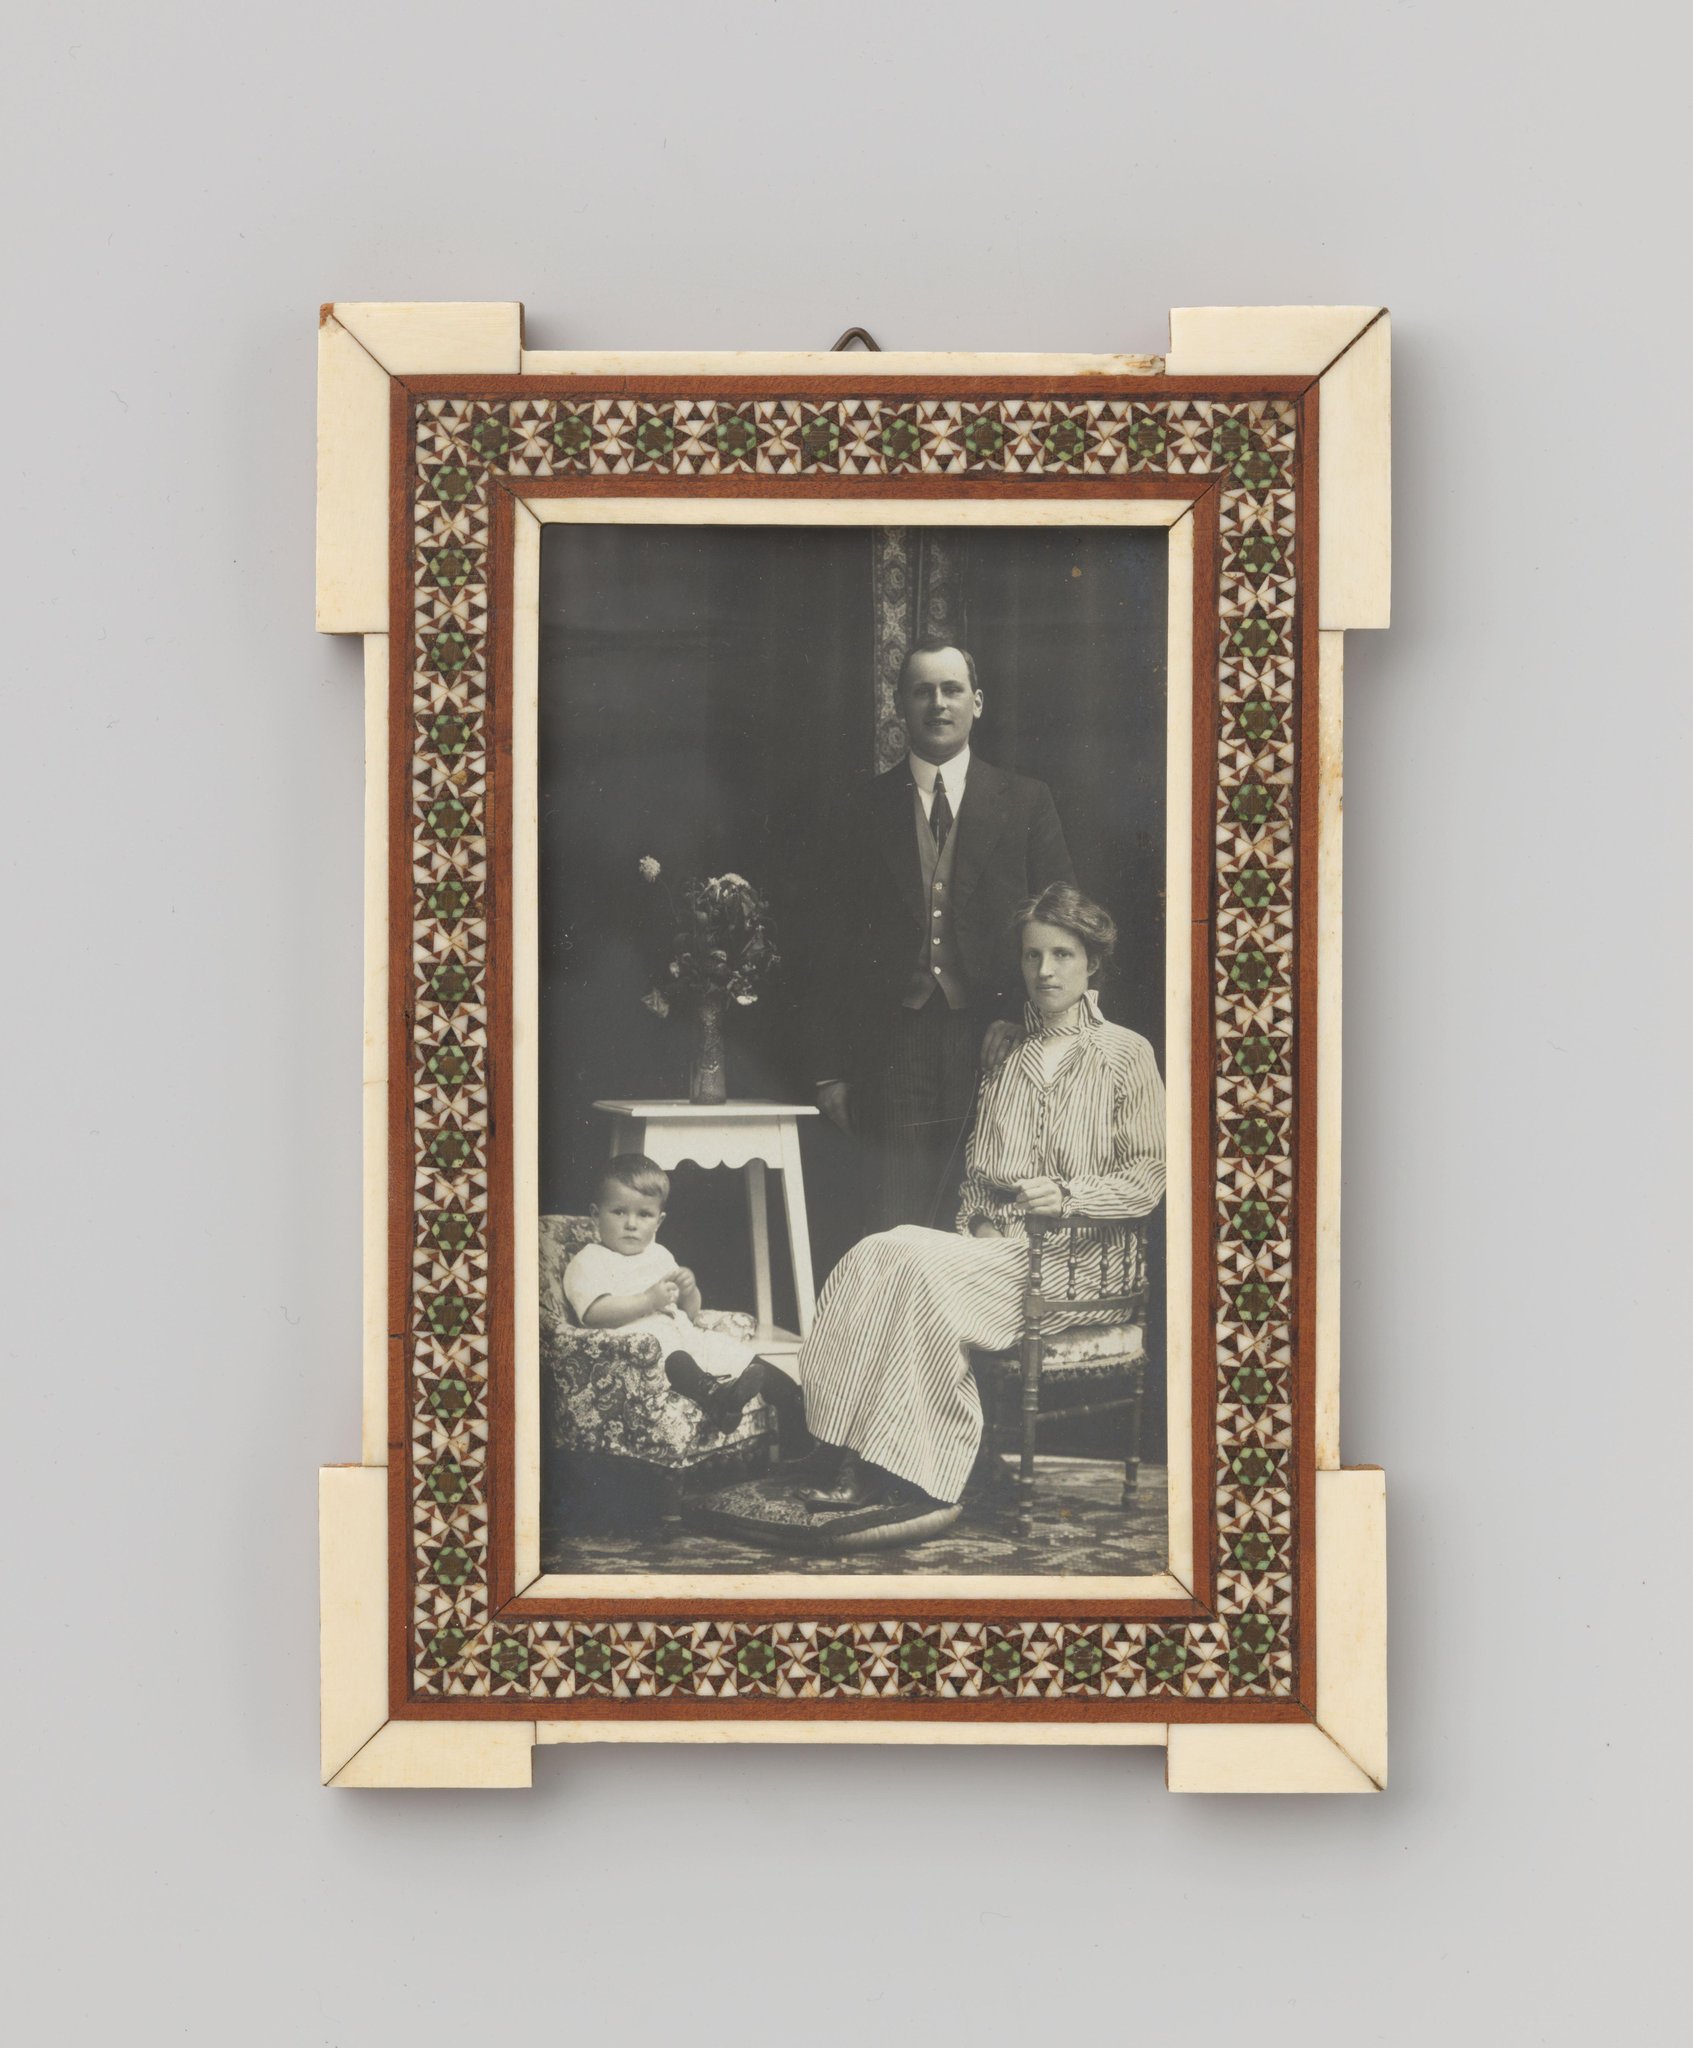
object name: photograph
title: Photo Frames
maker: Anonymous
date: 1880-1900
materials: paper, bone, glass, metal, wood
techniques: gelatin silver print, inlay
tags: parents with their children